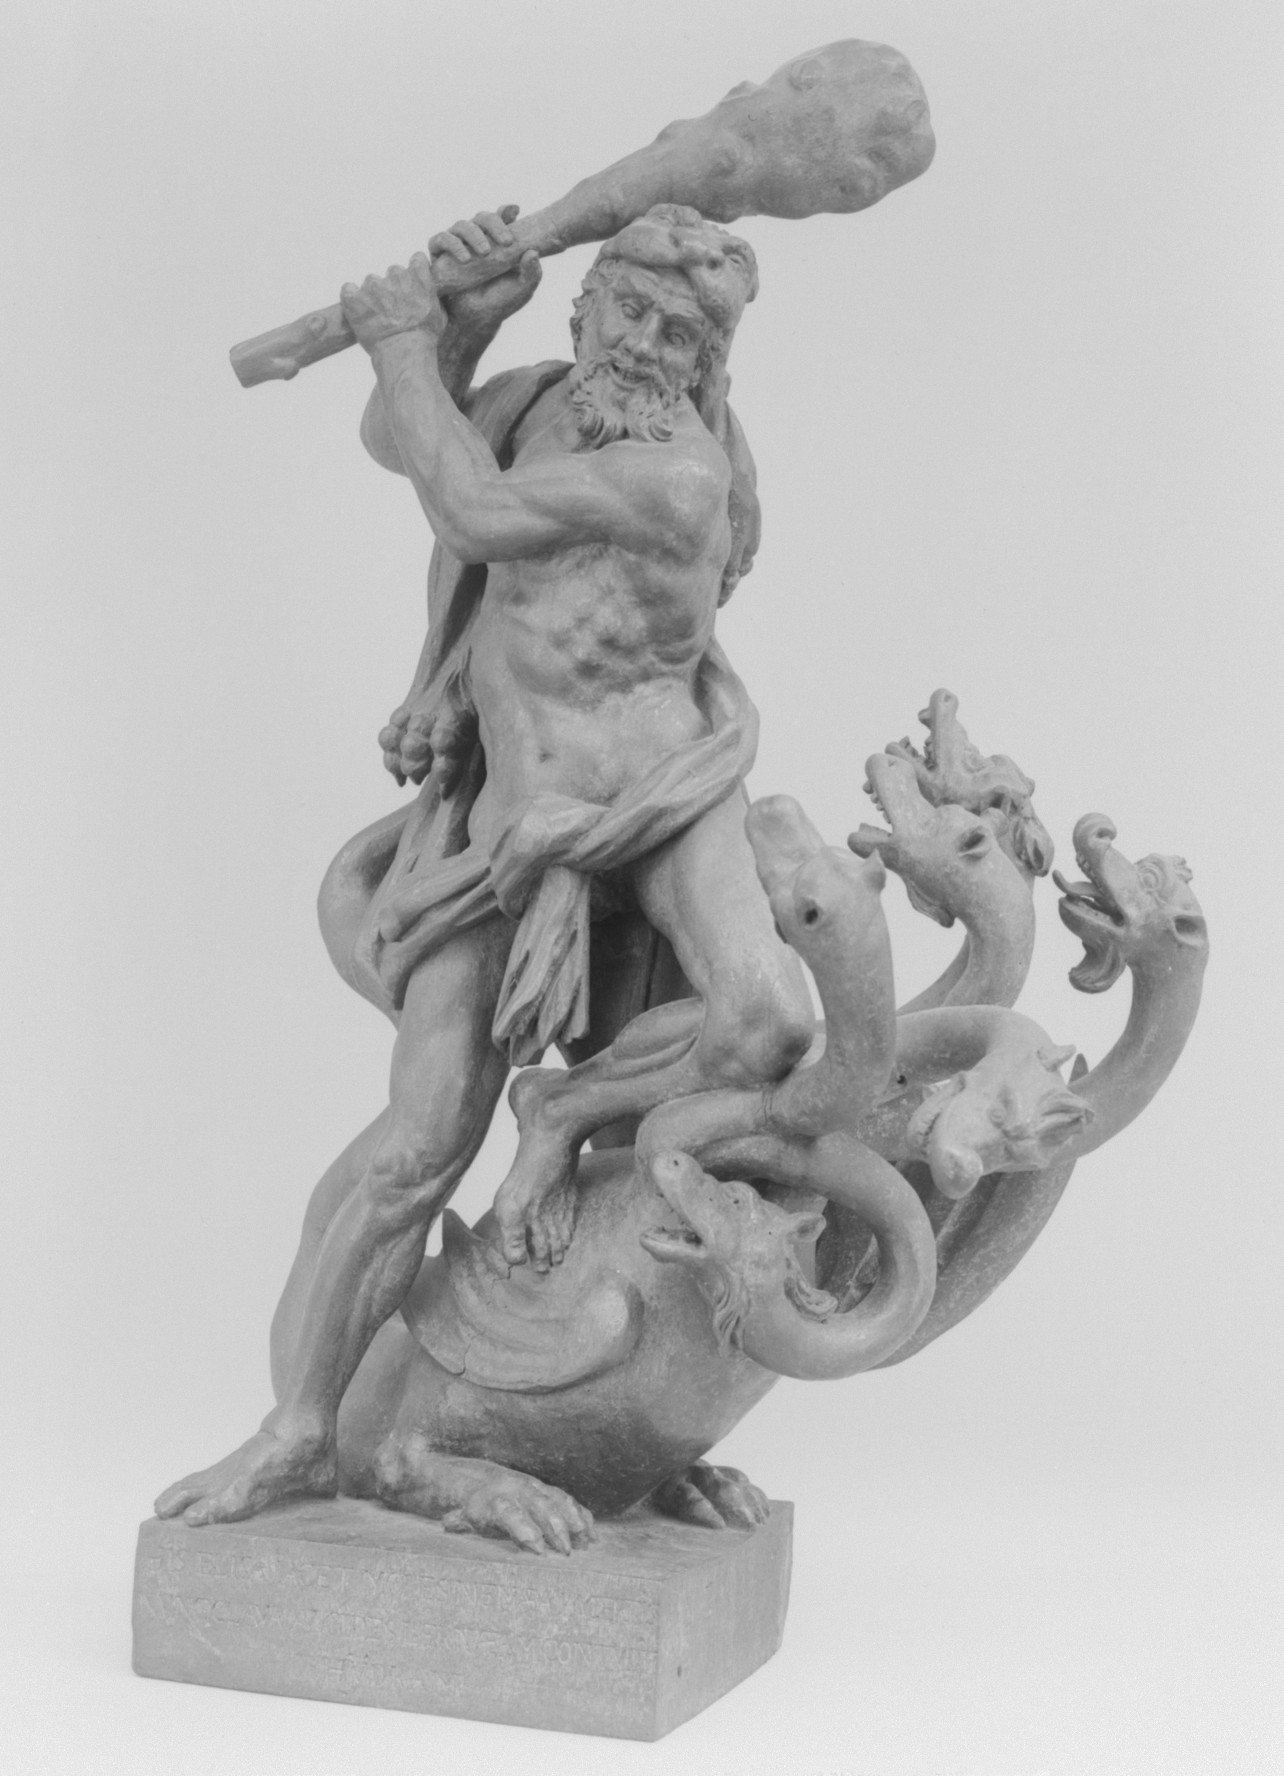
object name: statuette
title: Hercules slaying the Hydra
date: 1601-1700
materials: wood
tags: hercules